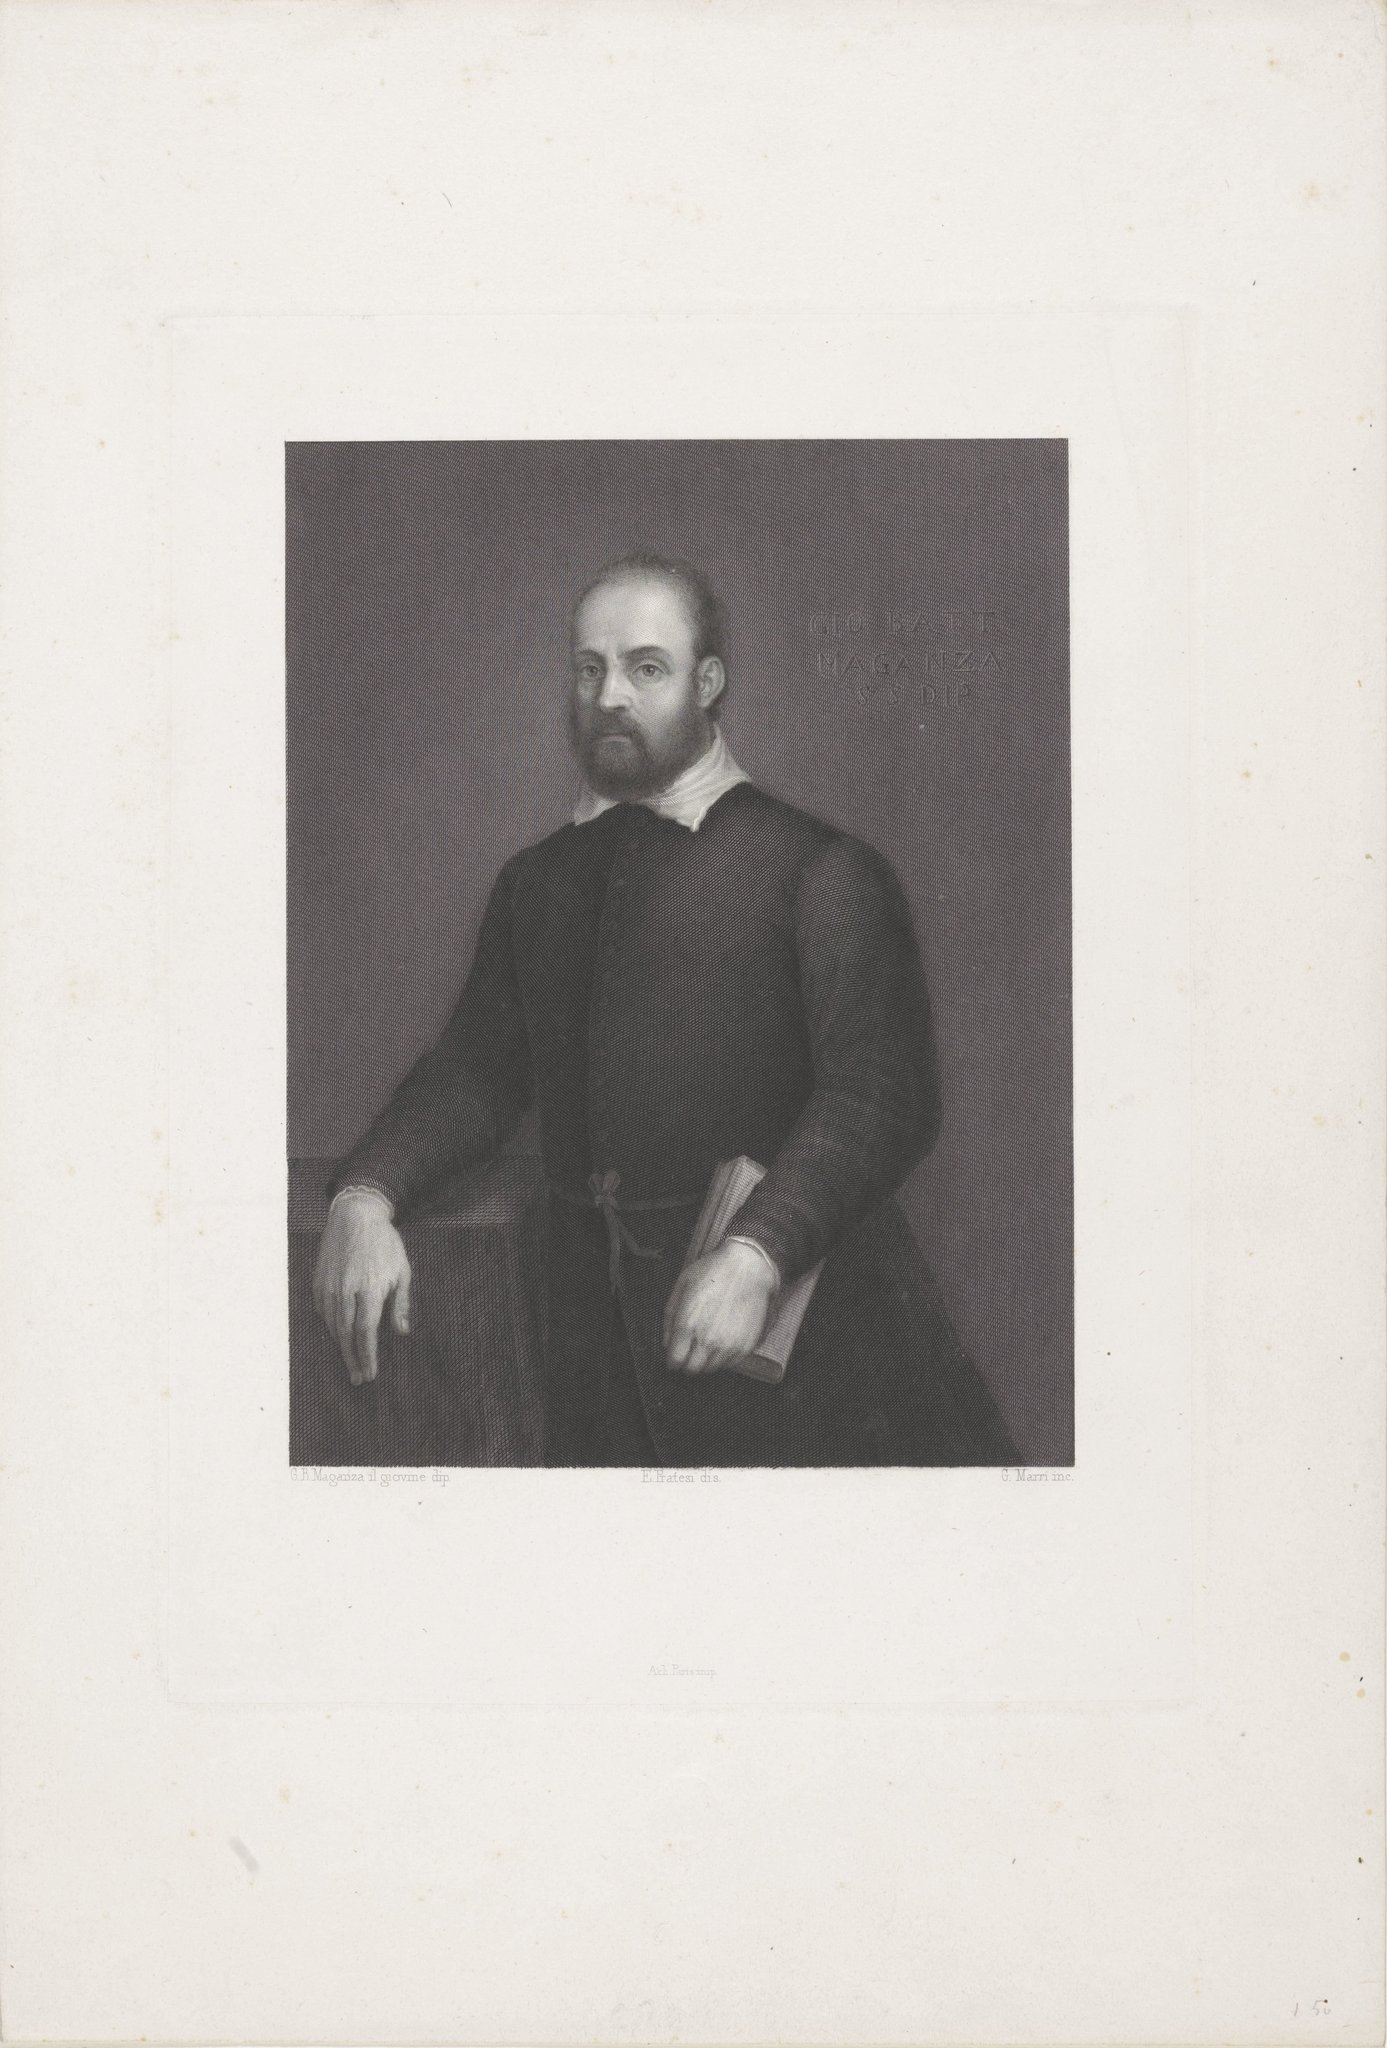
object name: print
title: Portret van dichter en schilder Giovanni Battista Maganza II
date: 1798-1852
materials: paper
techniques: engraving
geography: italy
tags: painter, giovanni battista maganza (ii), historical persons, portrait of a writer, portrait, self-portrait of artist, writer, poet, author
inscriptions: collector's mark: ‘Onduidelijk.’, collector's mark: Lugt 2228